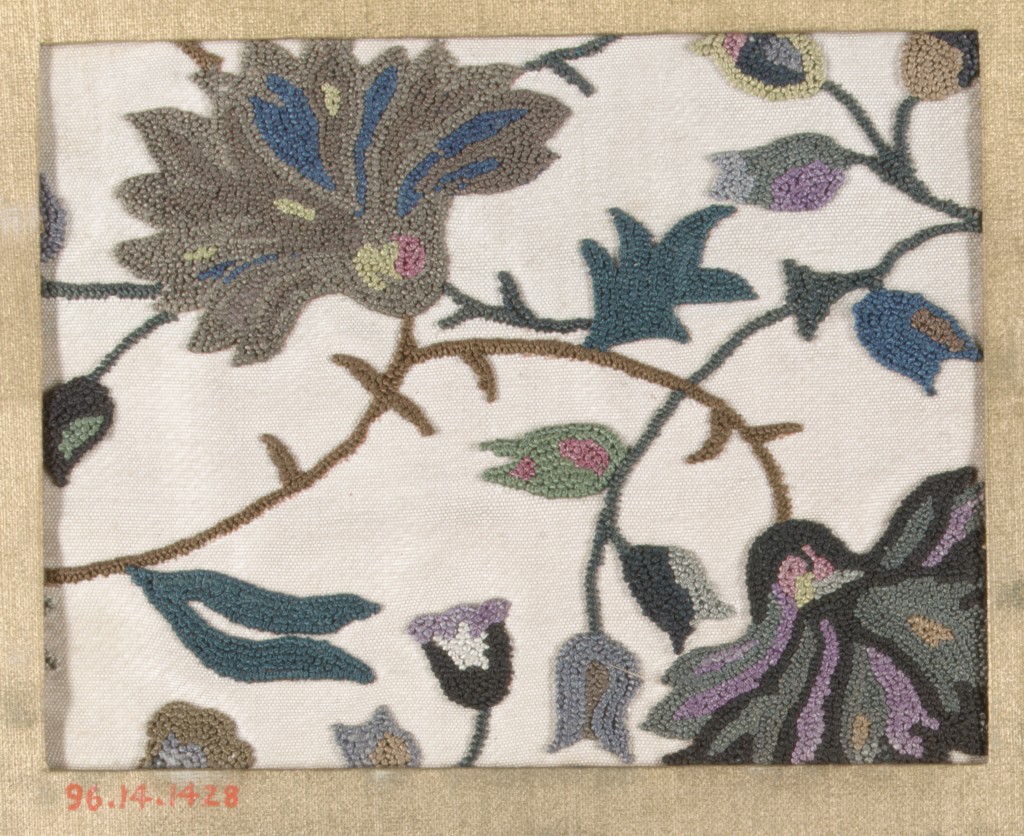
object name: piece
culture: japanese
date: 1701-1900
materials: silk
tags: leaves